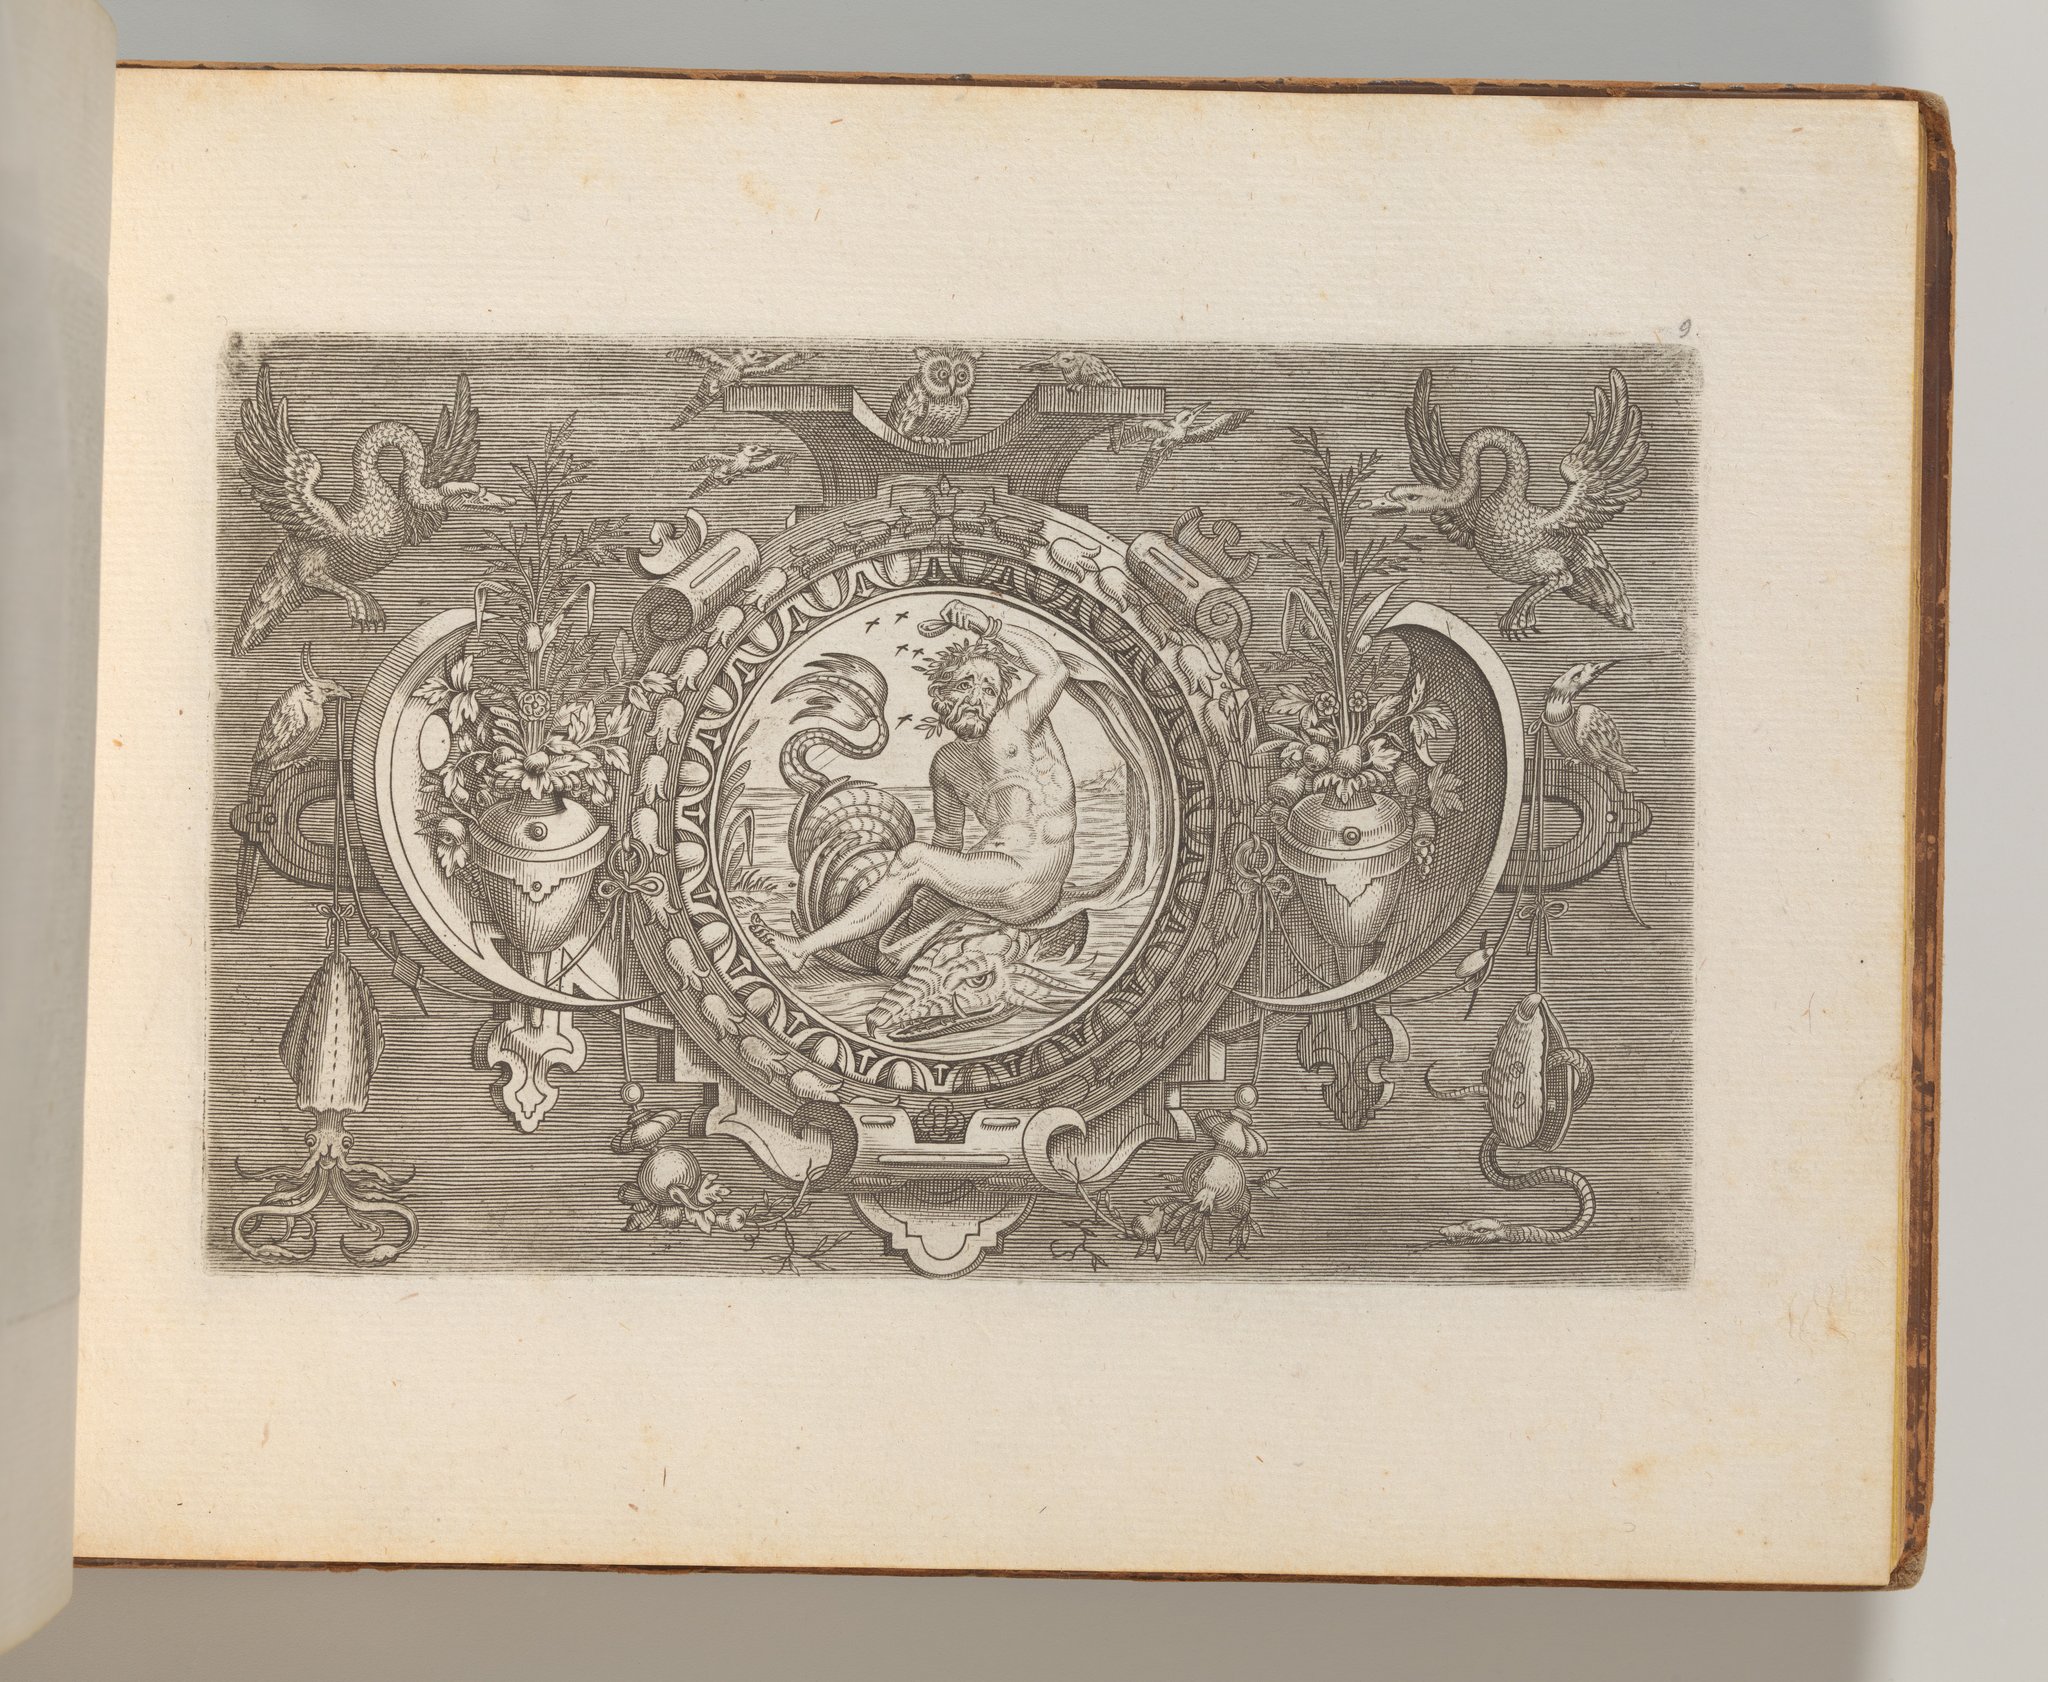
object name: album print ornament architecture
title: Targhe ed altri ornati di varie e capricciose invenzioni (Cartouches and other ornaments of various and capricious invention, page 9)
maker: jacob floris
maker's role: artist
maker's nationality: central european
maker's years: 1524-1581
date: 1773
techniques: engraving, etching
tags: birds,cartouches,male nudes